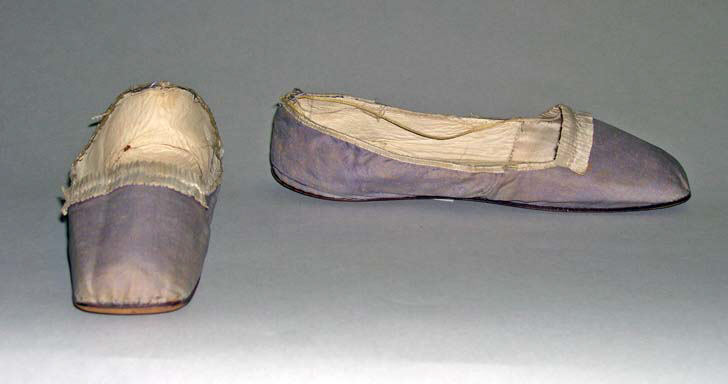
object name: slipper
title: Slippers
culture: american or european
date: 1830-1839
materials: silk